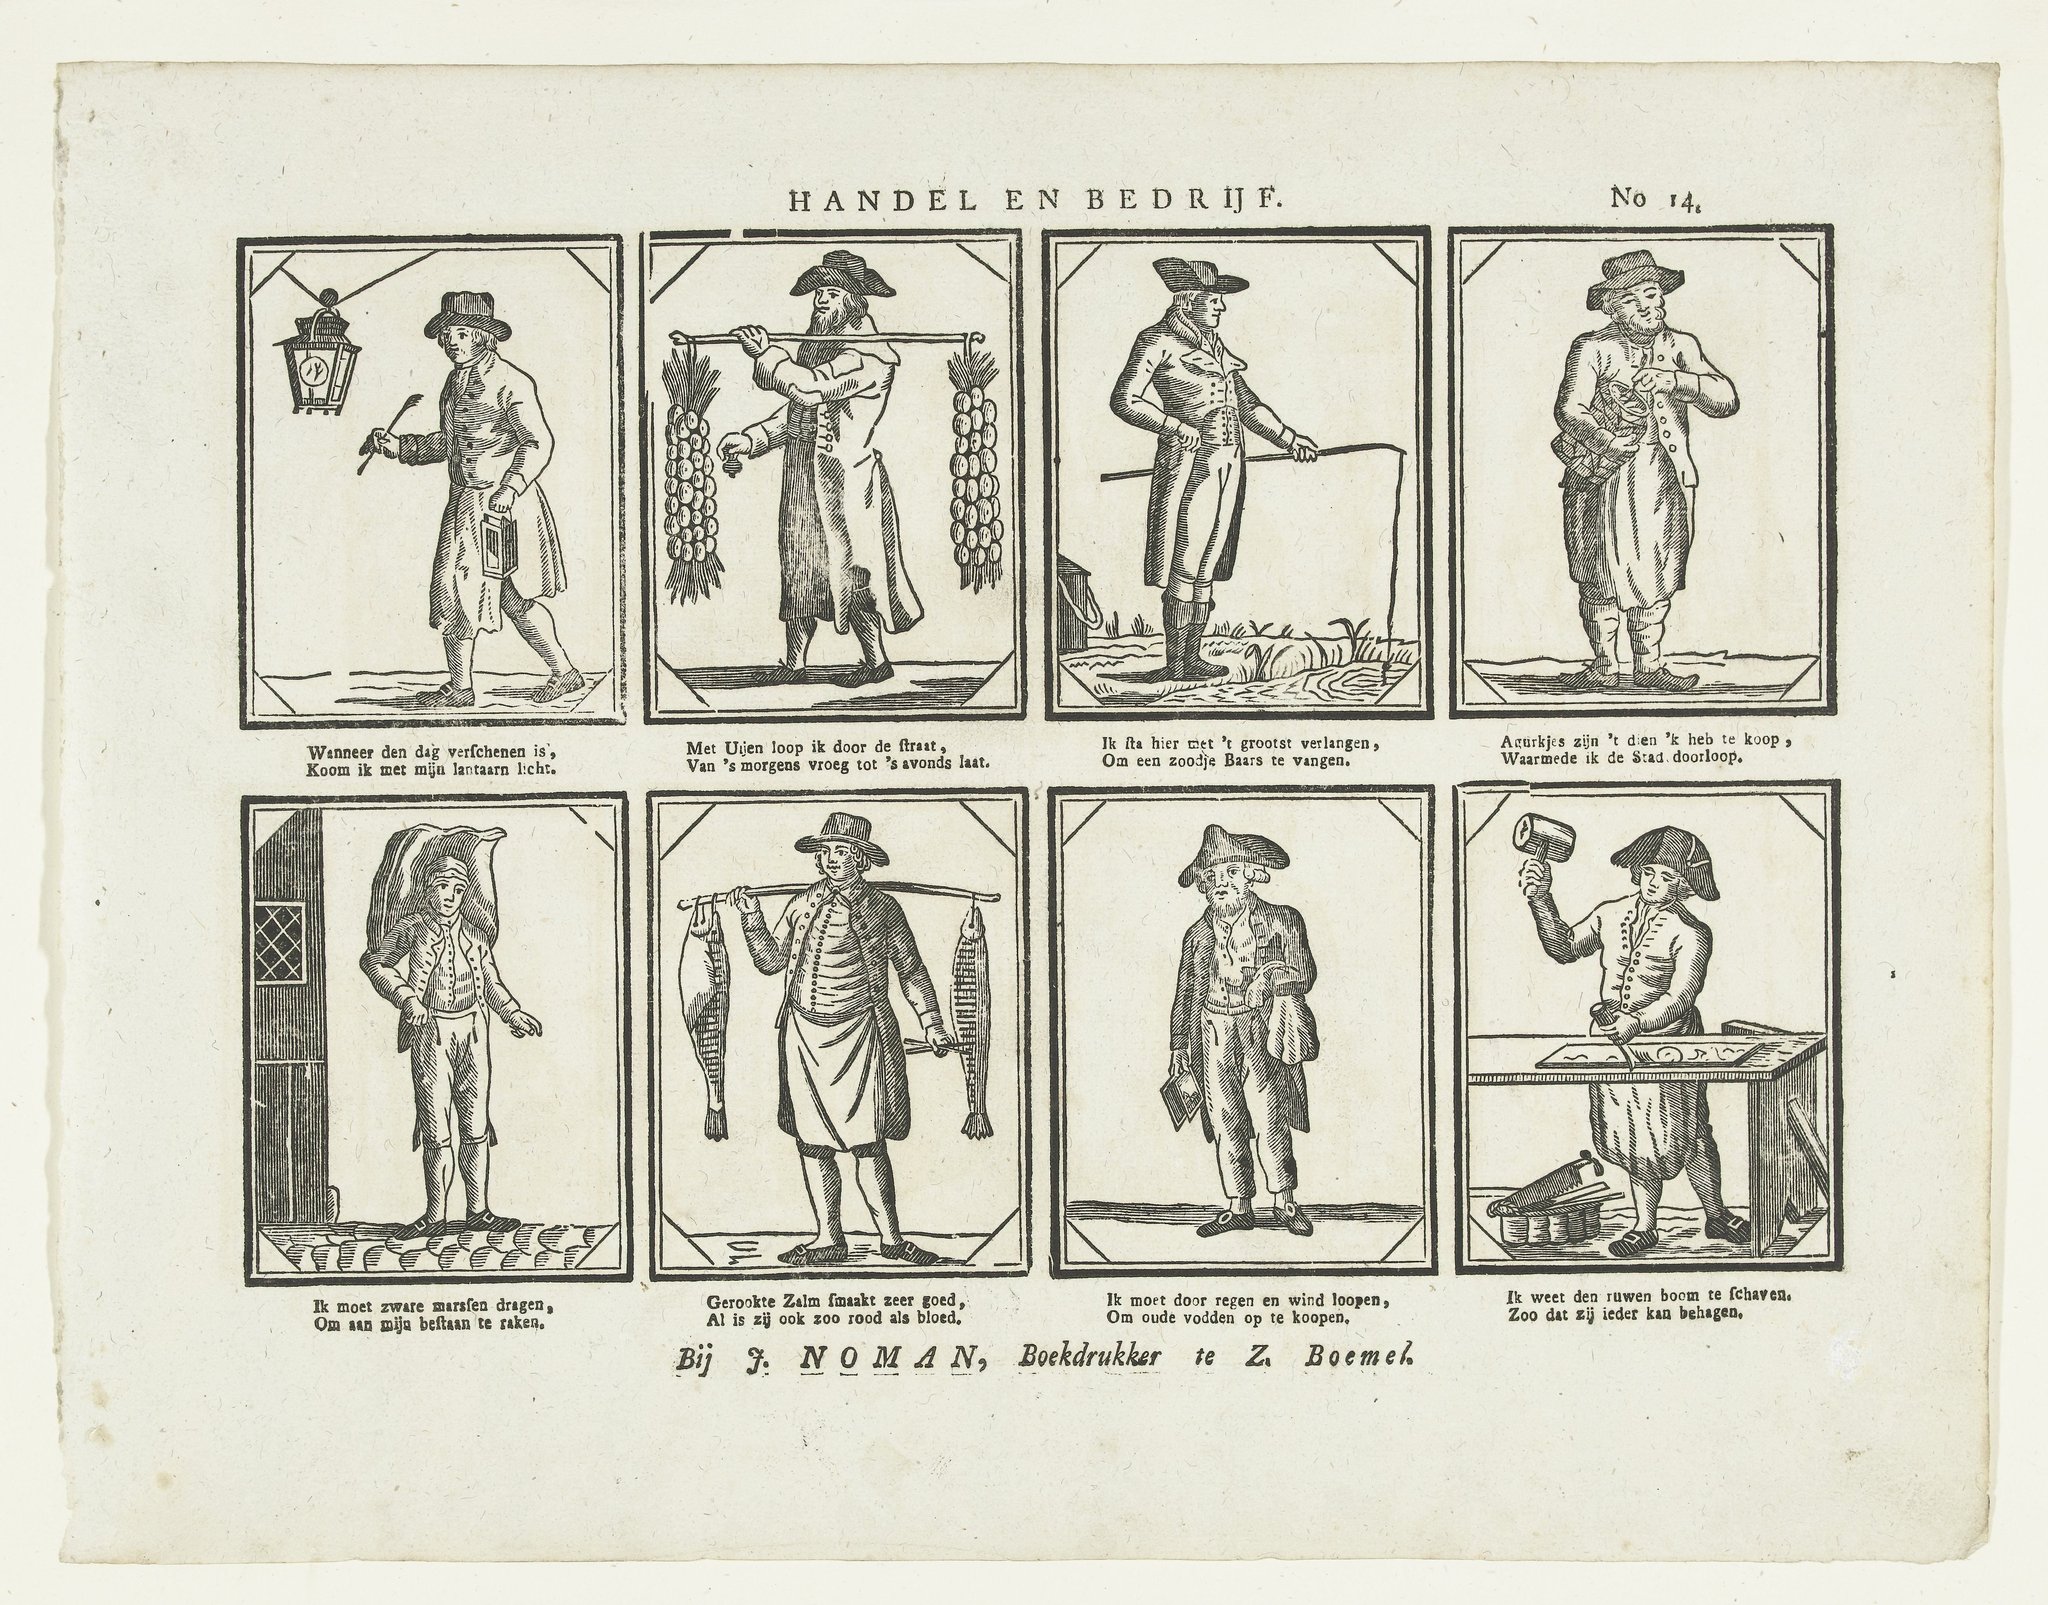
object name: print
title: Handel en bedrijf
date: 1806-1830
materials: paper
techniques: letterpress printing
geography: netherlands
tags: craft-production, skilled handiwork, street-trader, crafts and industries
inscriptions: collector's mark: Lugt 2760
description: Blad met 8 voorstellingen van ambachtslieden en beroepen, zoals straatverkoper en houtbewerker. Onder elke afbeelding een tweeregelig vers. Genummerd rechtsboven: No 14.